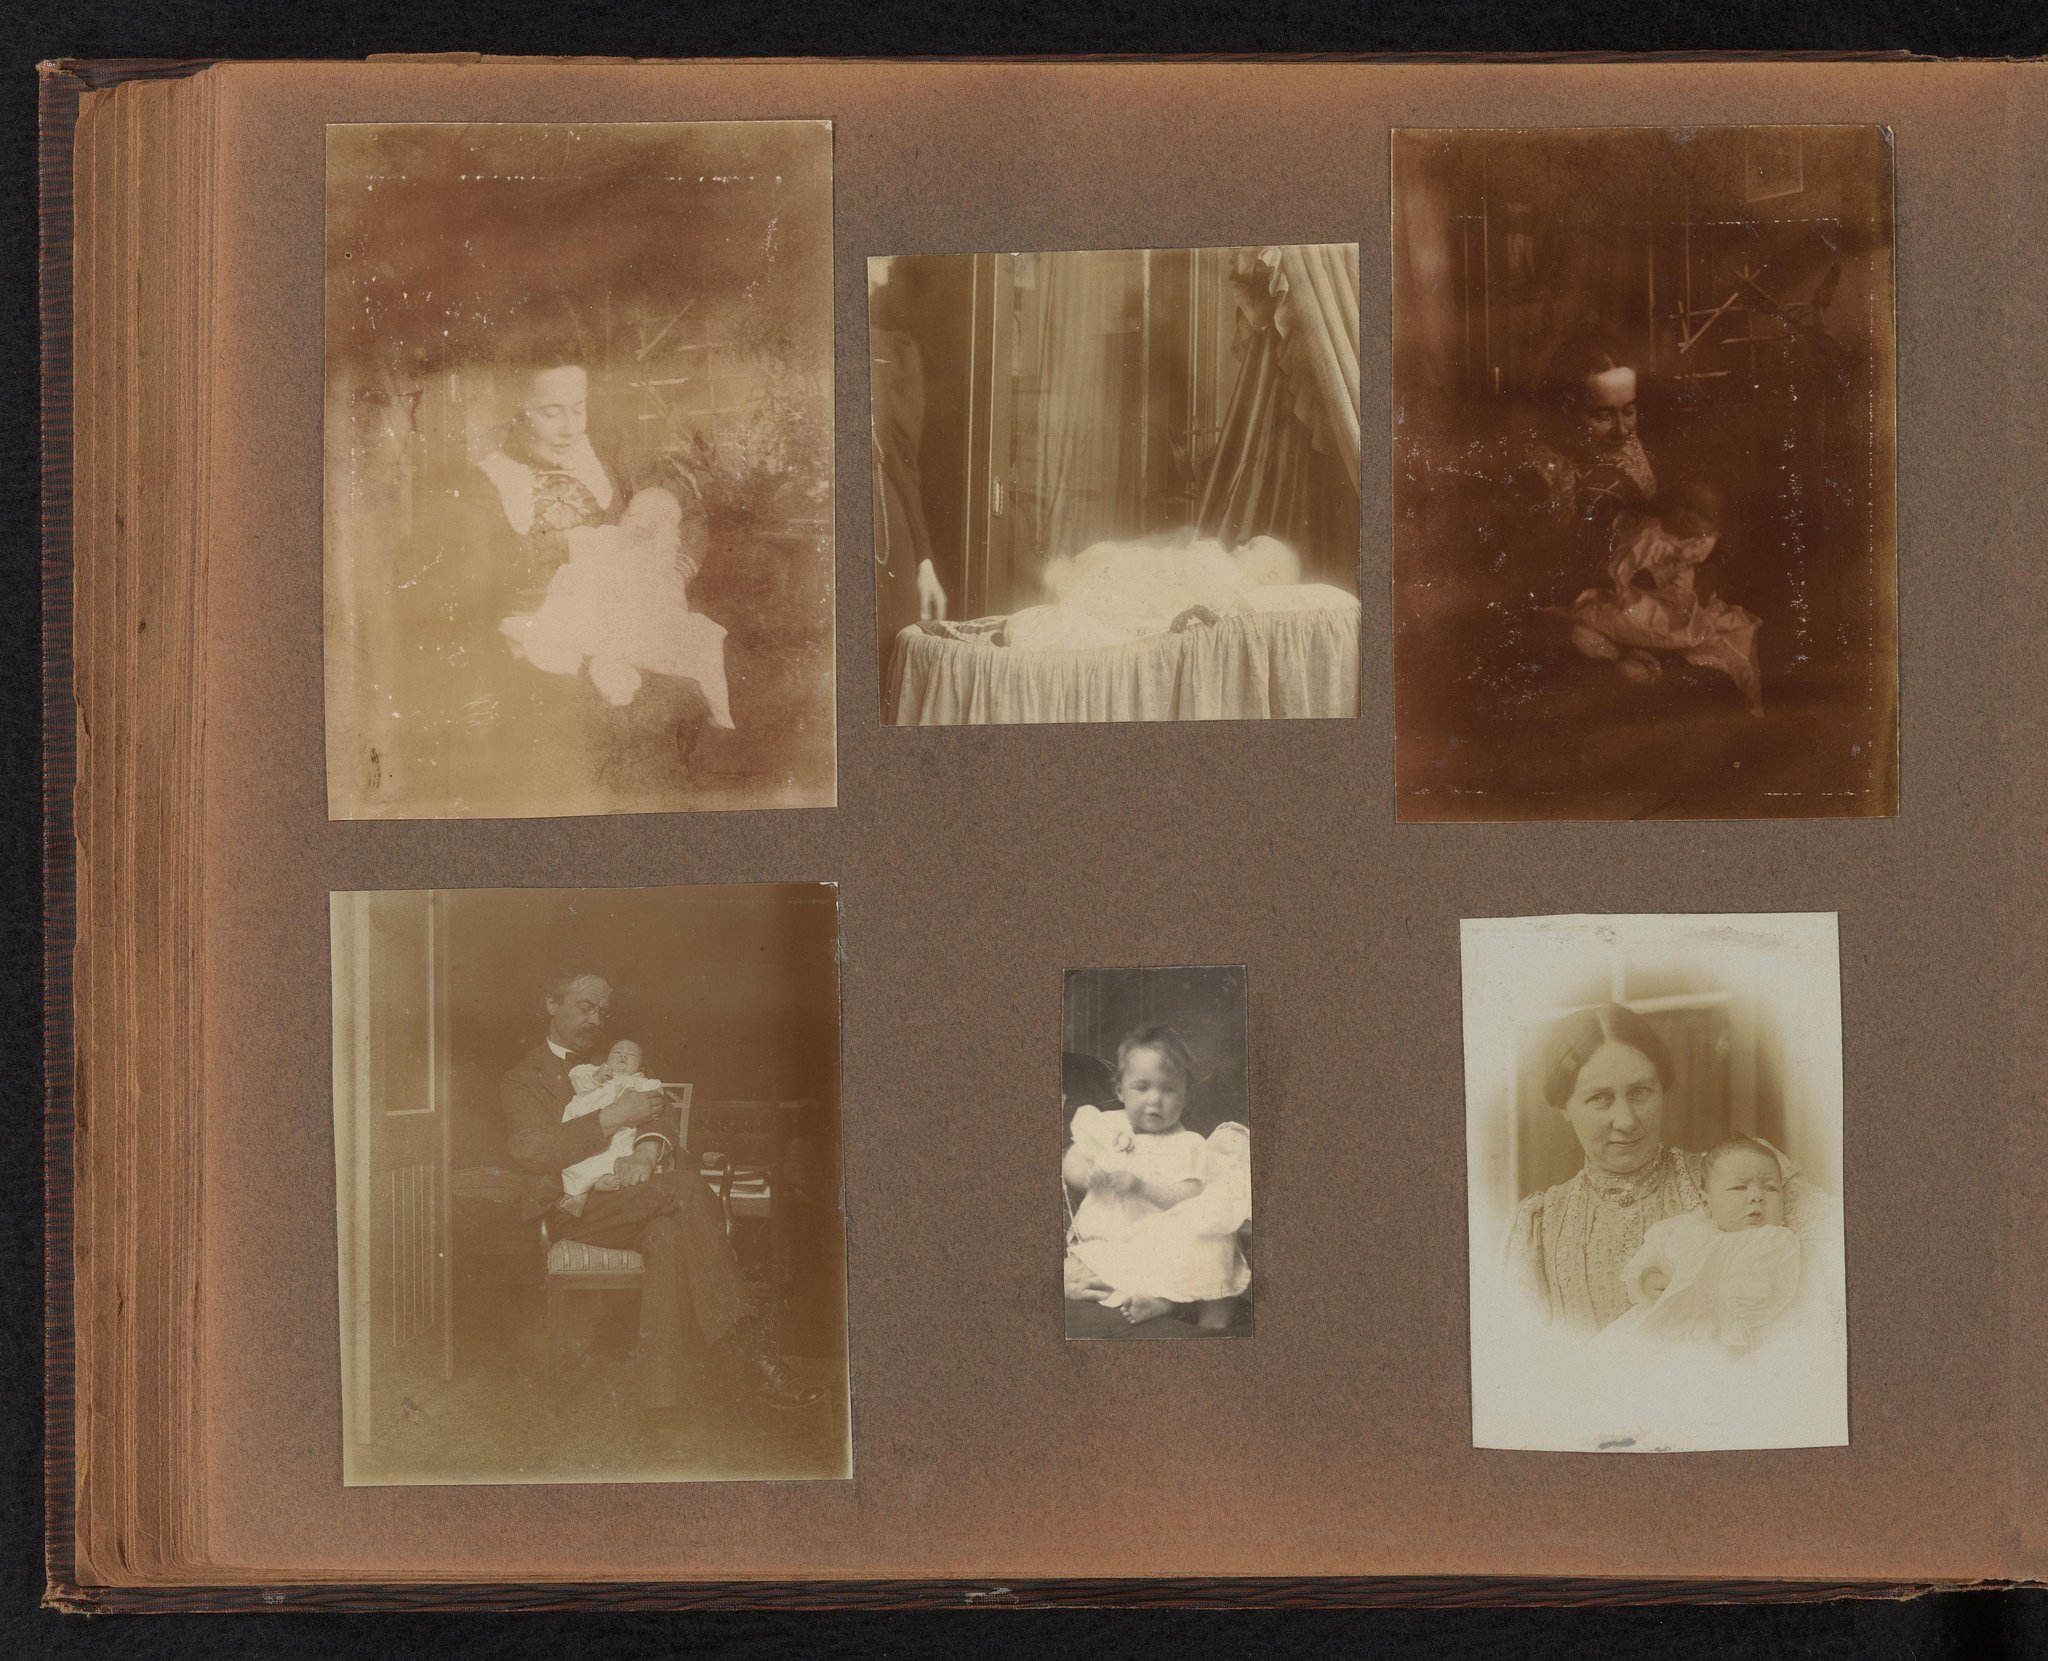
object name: photograph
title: Bladzijde uit het fotoalbum van de familie Diepenbrock met 6 foto's van Alphons Diepenbrock en zijn omgeving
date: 1870-1920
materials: cardboard, photographic support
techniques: photography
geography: amsterdam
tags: alphons diepenbrock, jonkvrouw wilhelmina elisabeth petronella cornelia de jong van beek en donk, netherlands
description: Bruin albumblad 42 van familiealbum van Alphons Diepenbrock.